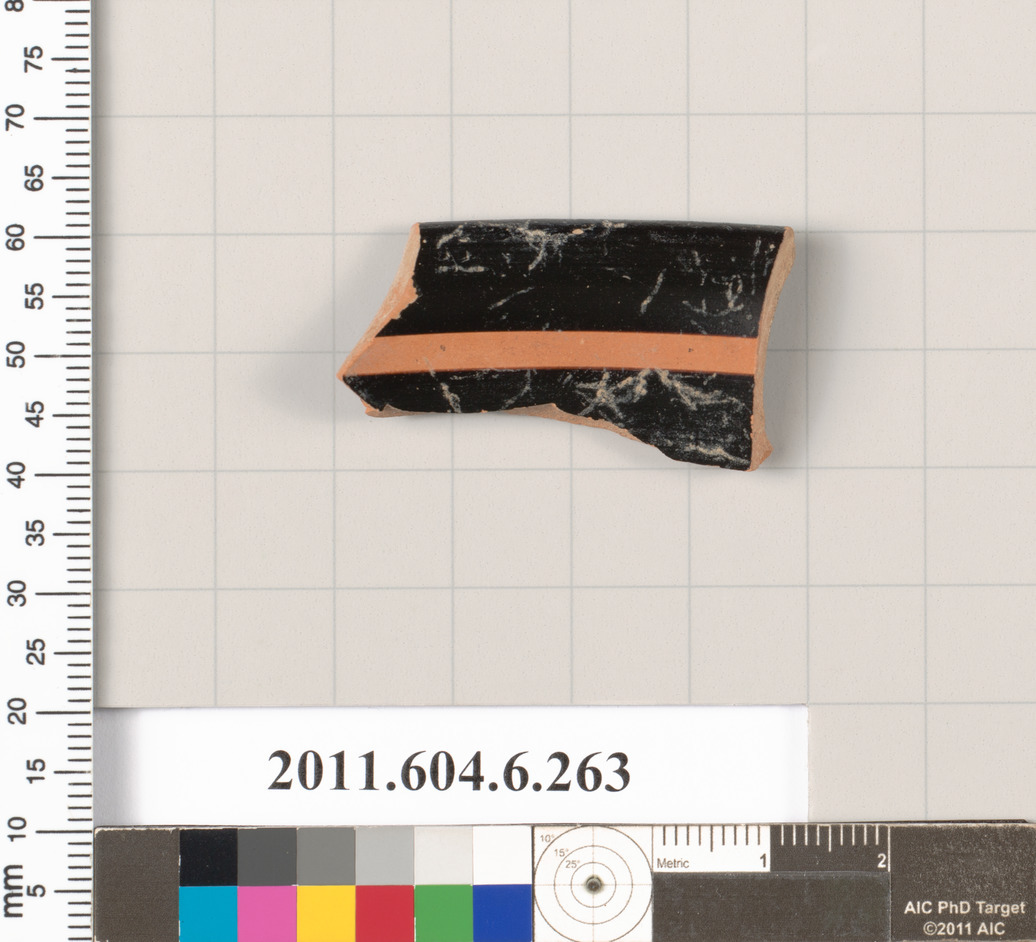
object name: undetermined open shape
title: Terracotta rim fragment of an open shape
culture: greek, attic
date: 500-401 BCE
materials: terracotta